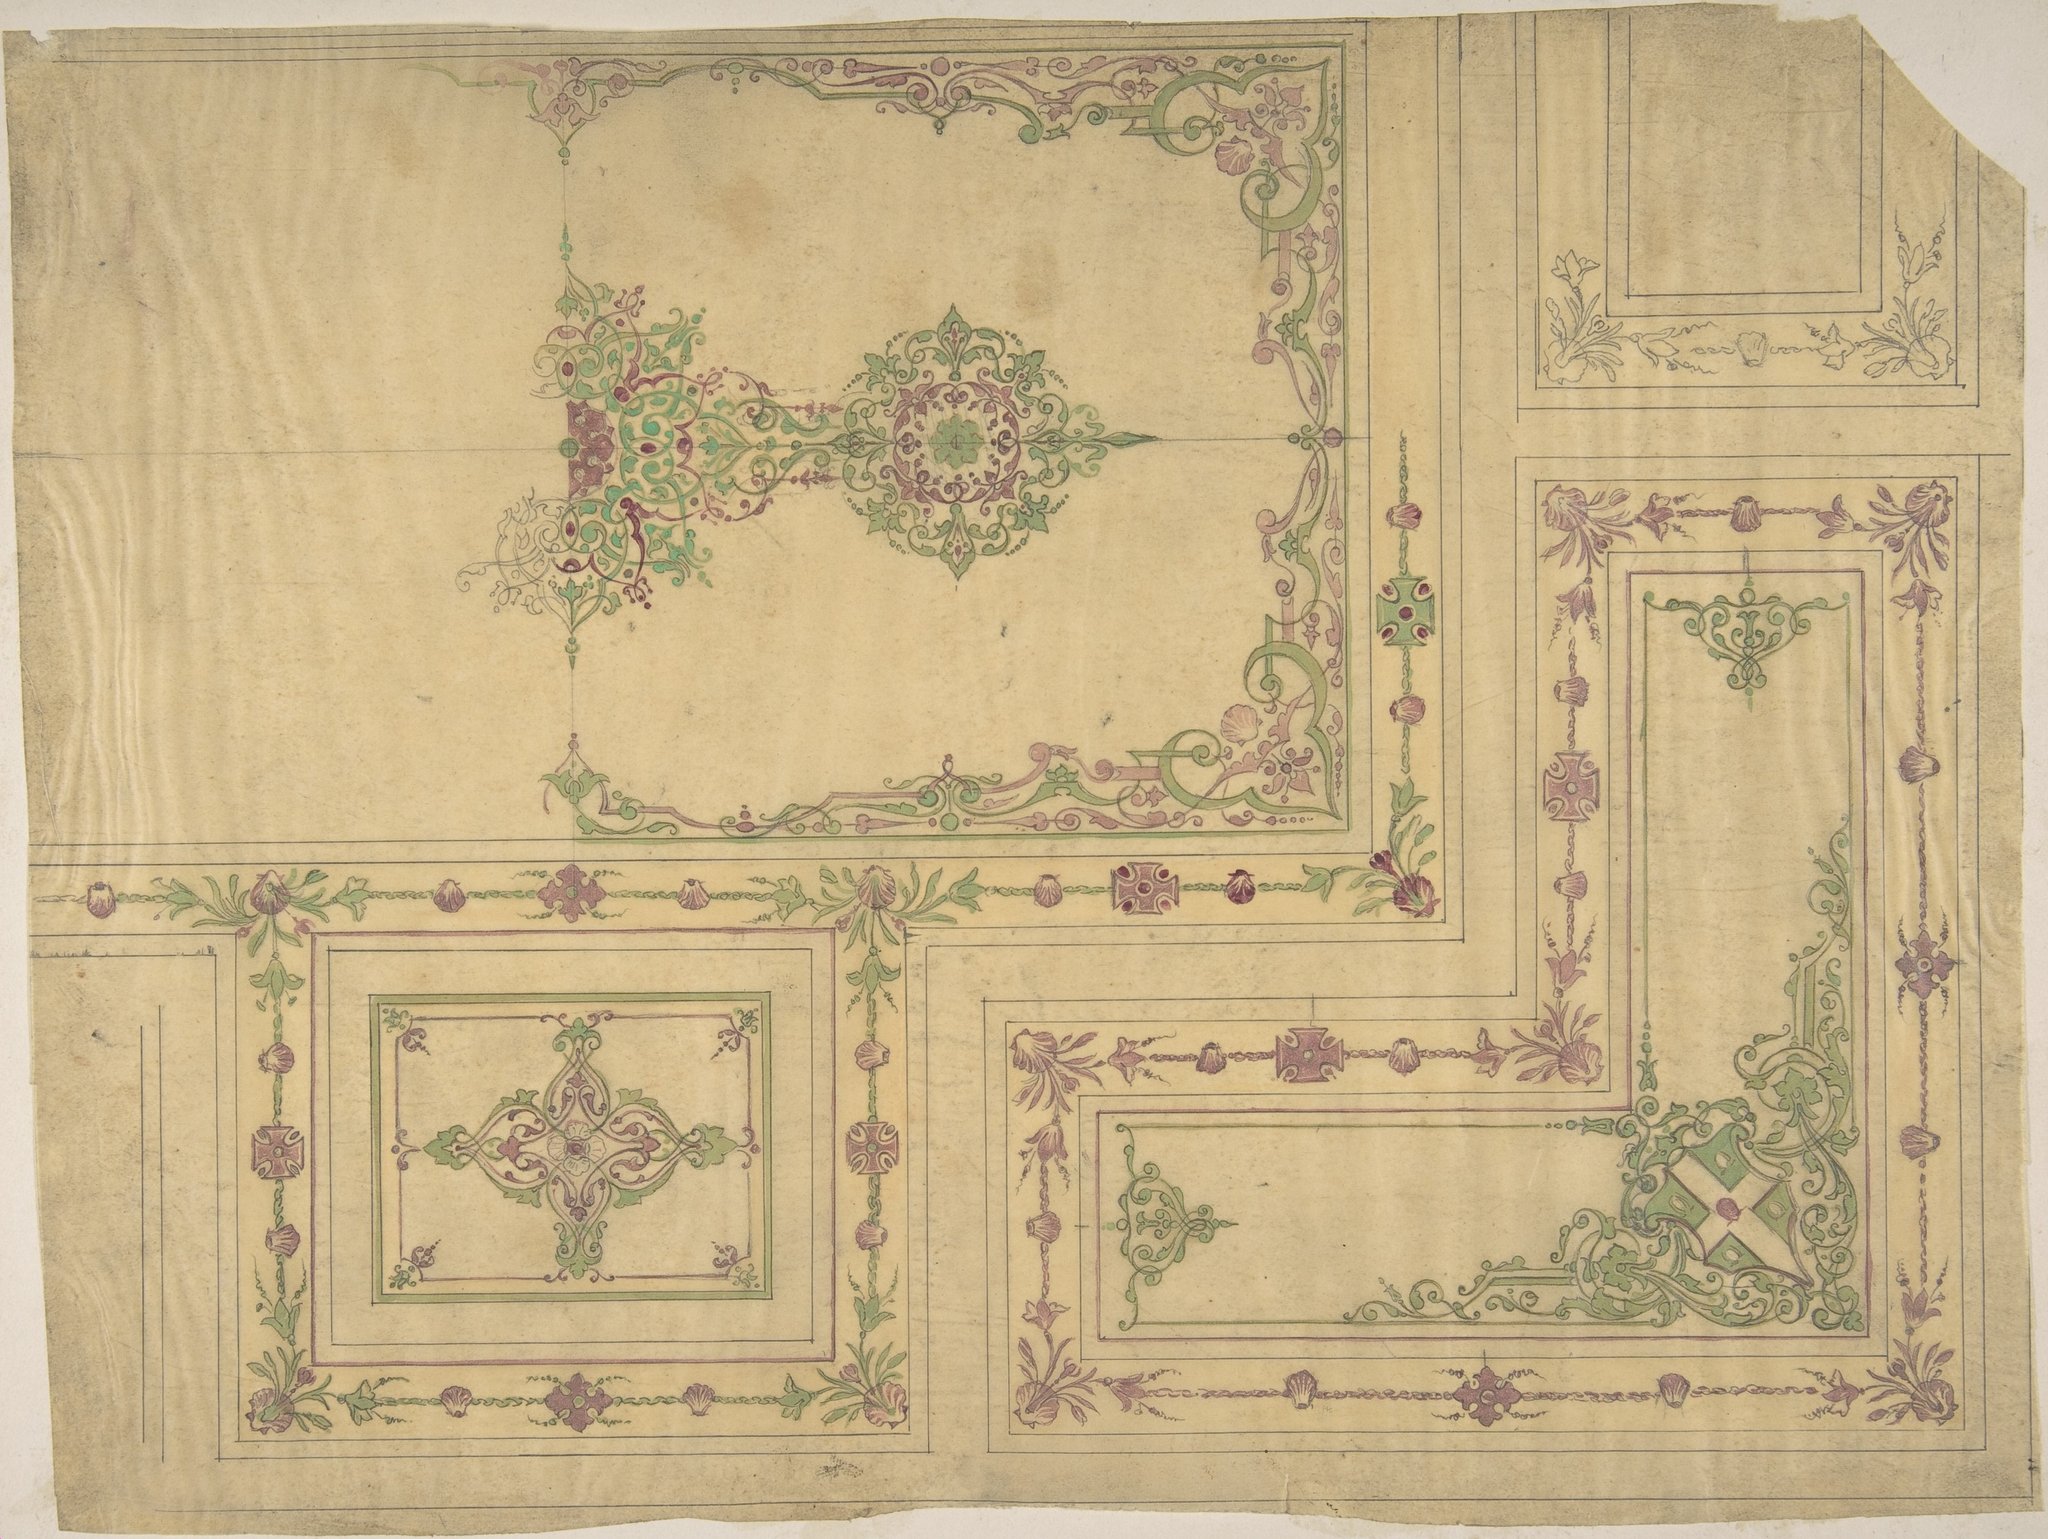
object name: drawing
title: Ceiling Design in Moorish Style for the de la Rochejaquelein Family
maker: jules-edmond-charles lachaise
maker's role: artist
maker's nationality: french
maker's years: 1897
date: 1851-1900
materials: graphite, ink, watercolor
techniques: pen